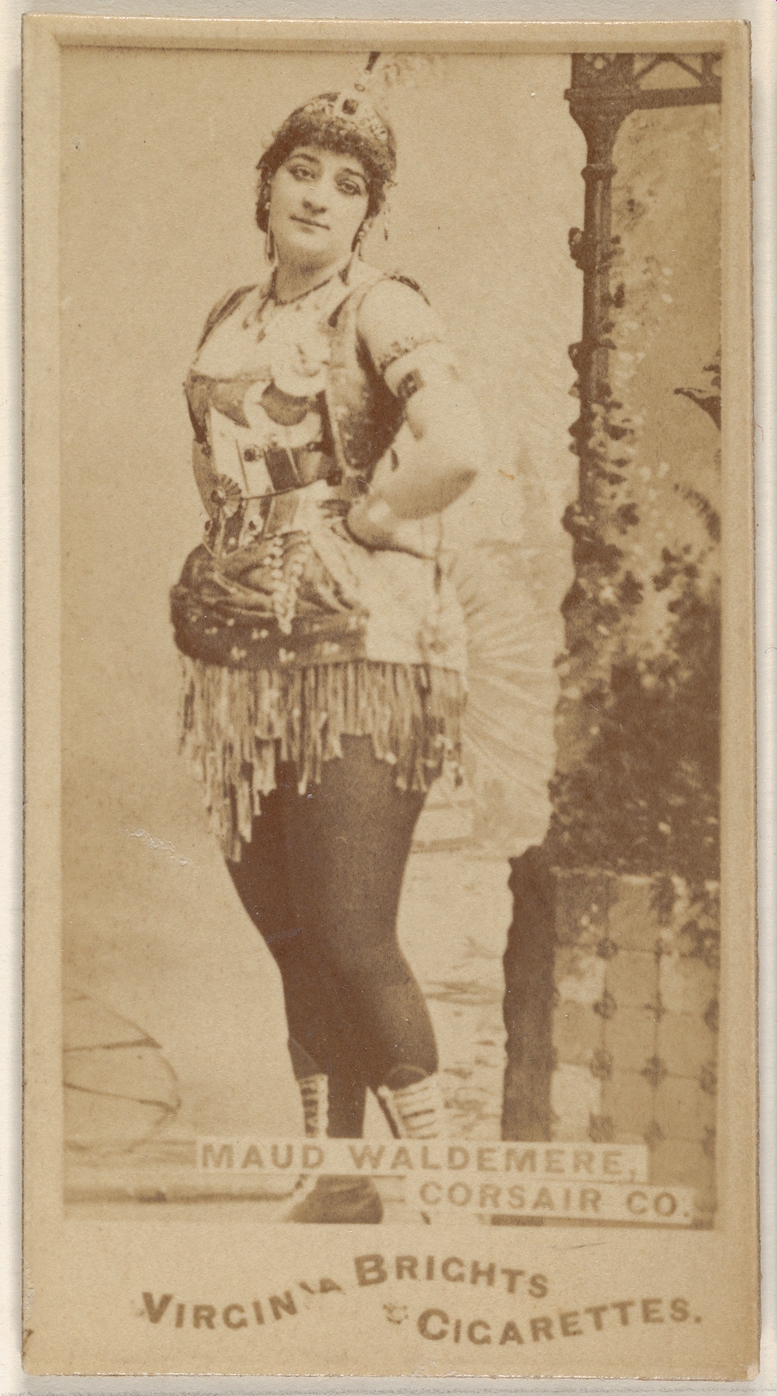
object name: photograph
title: Maud Waldemere, Corsair Co., from the Actors and Actresses series (N45, Type 1) for Virginia Brights Cigarettes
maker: allen & ginter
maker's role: publisher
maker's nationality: american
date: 1888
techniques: albumen silver print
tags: portraits,women,actresses